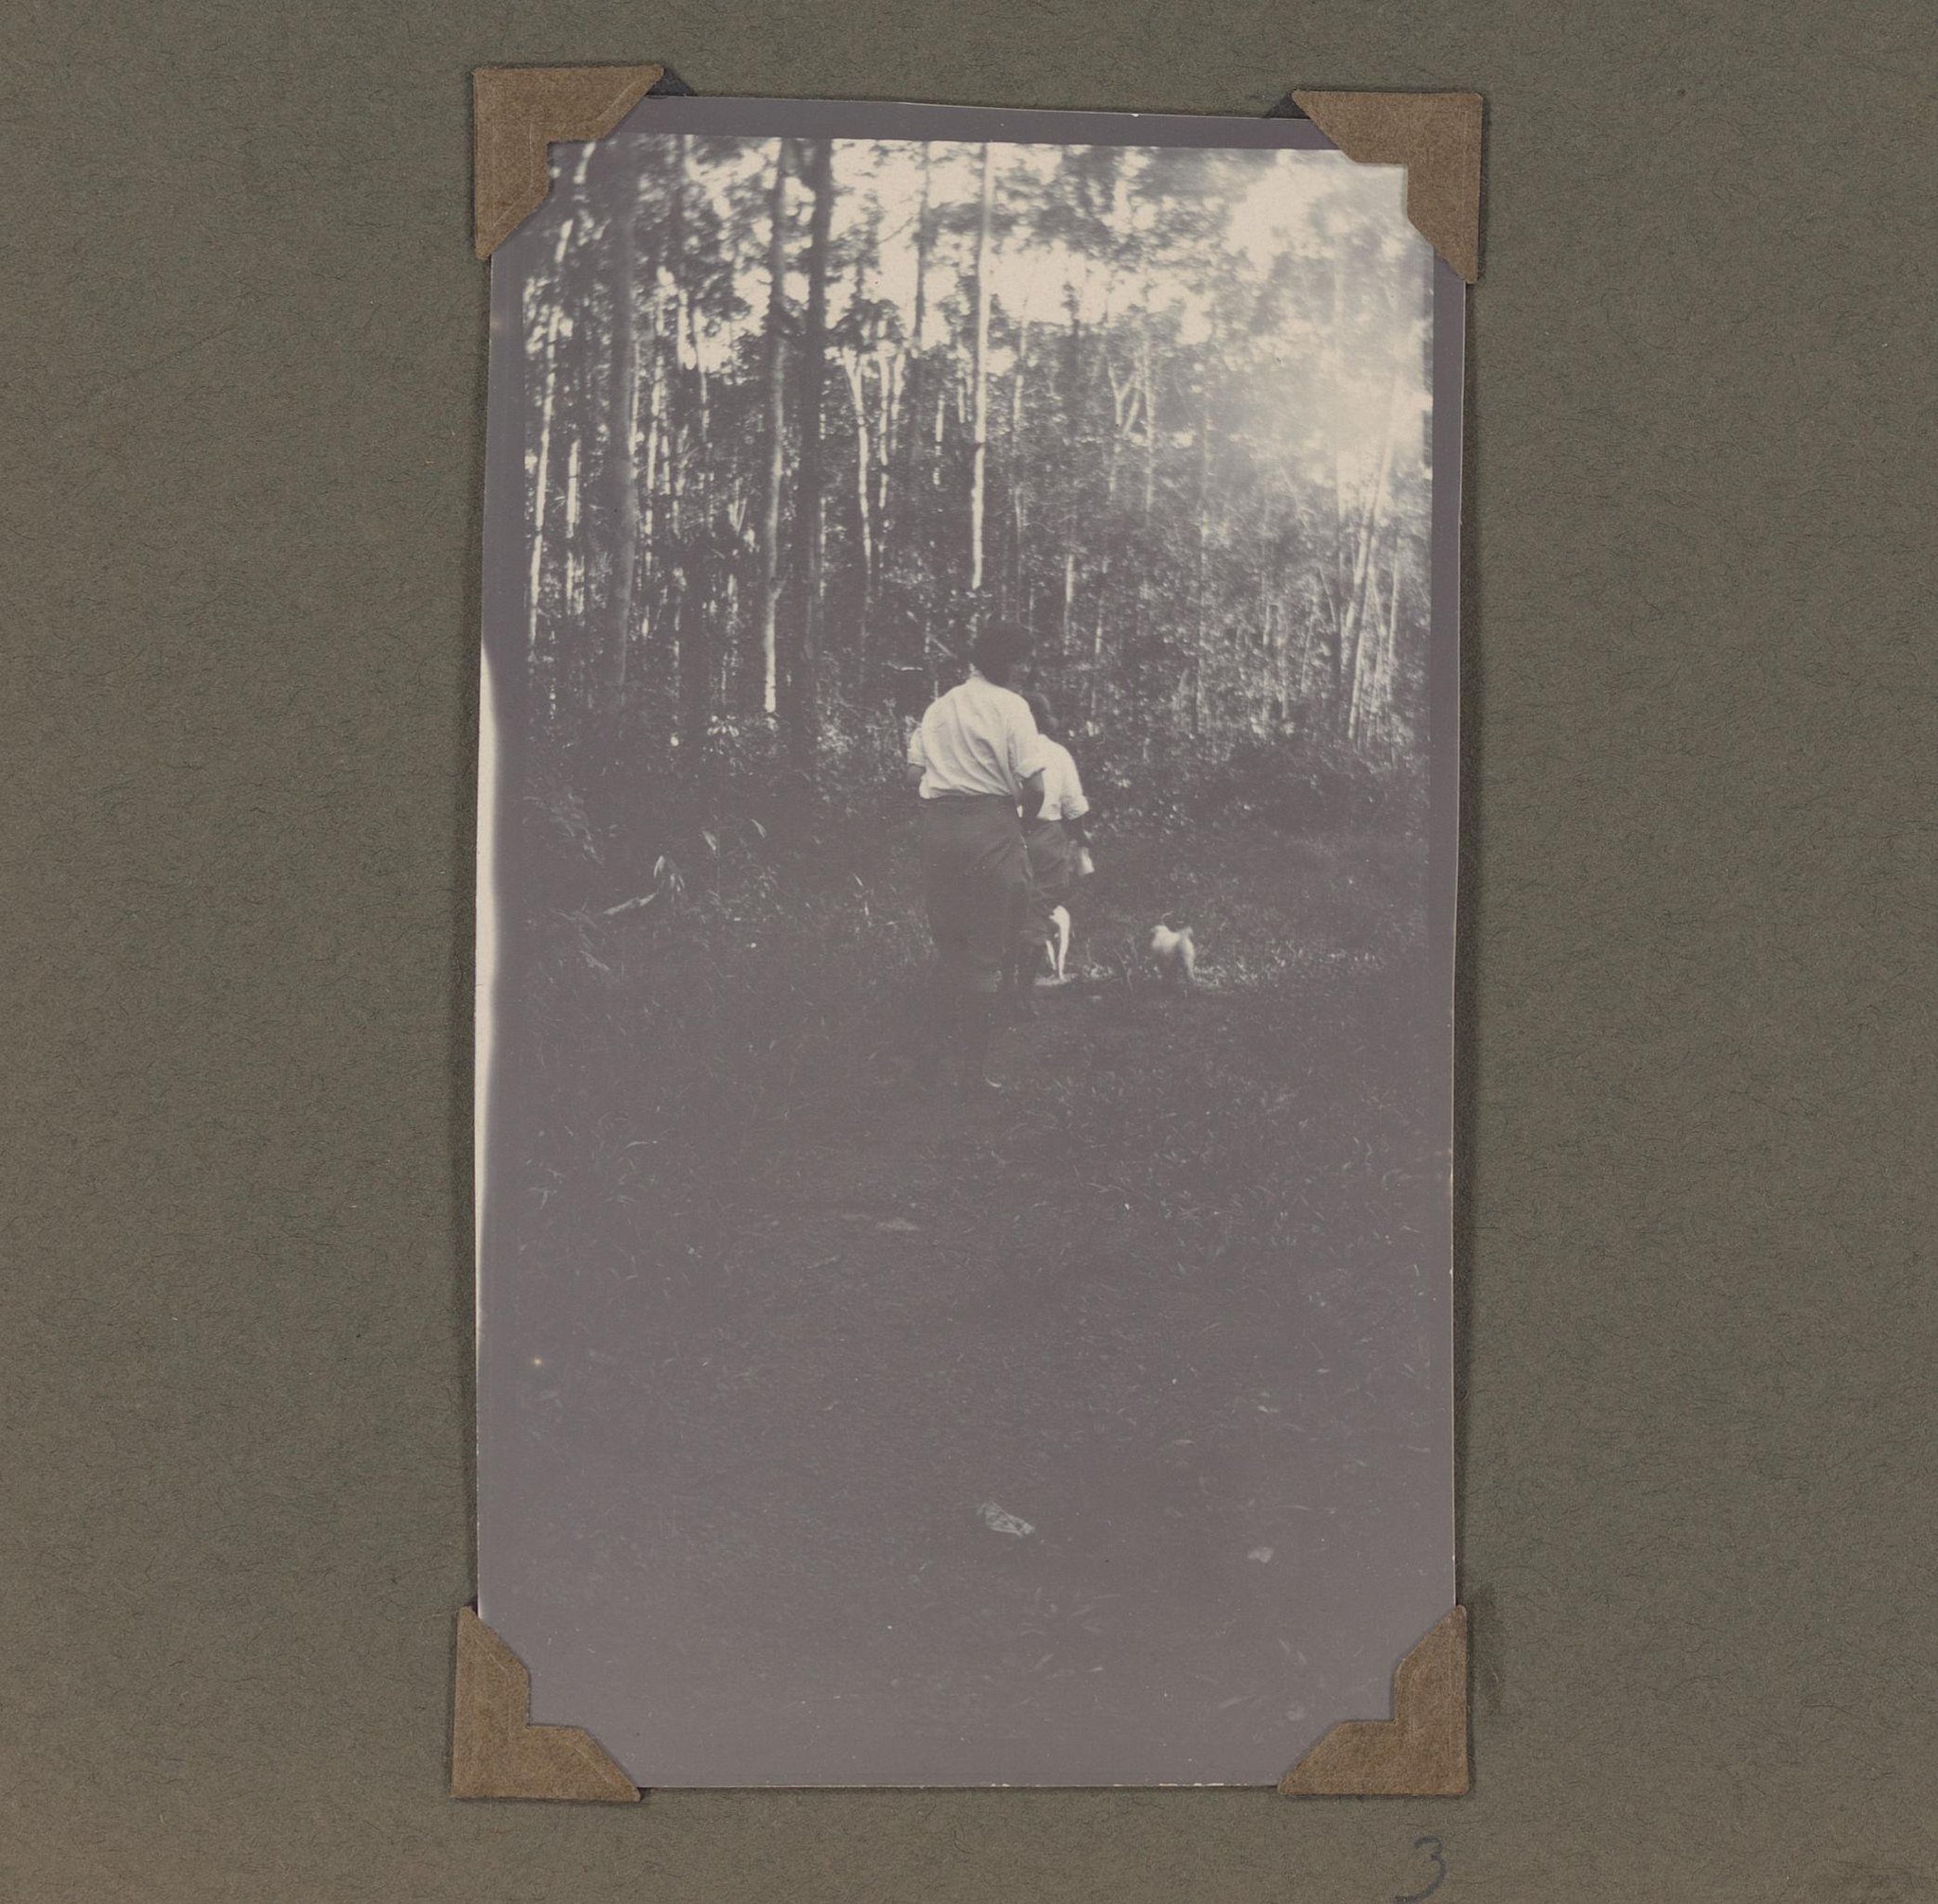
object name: photograph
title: Edith Jetten en een andere vrouw op een bospad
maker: Anonymous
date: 1925-1927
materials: photographic support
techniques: photography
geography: suriname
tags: jetten, familie, moengo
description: Edith Jetten en een andere vrouw op een bospad, met twee hondjes. Foto op een bladzijde van een los albumblad. Onderdeel van het ensemble met foto's van de familie van ingenieur Jetten in de mijnbouwstad Moengo in Suriname.